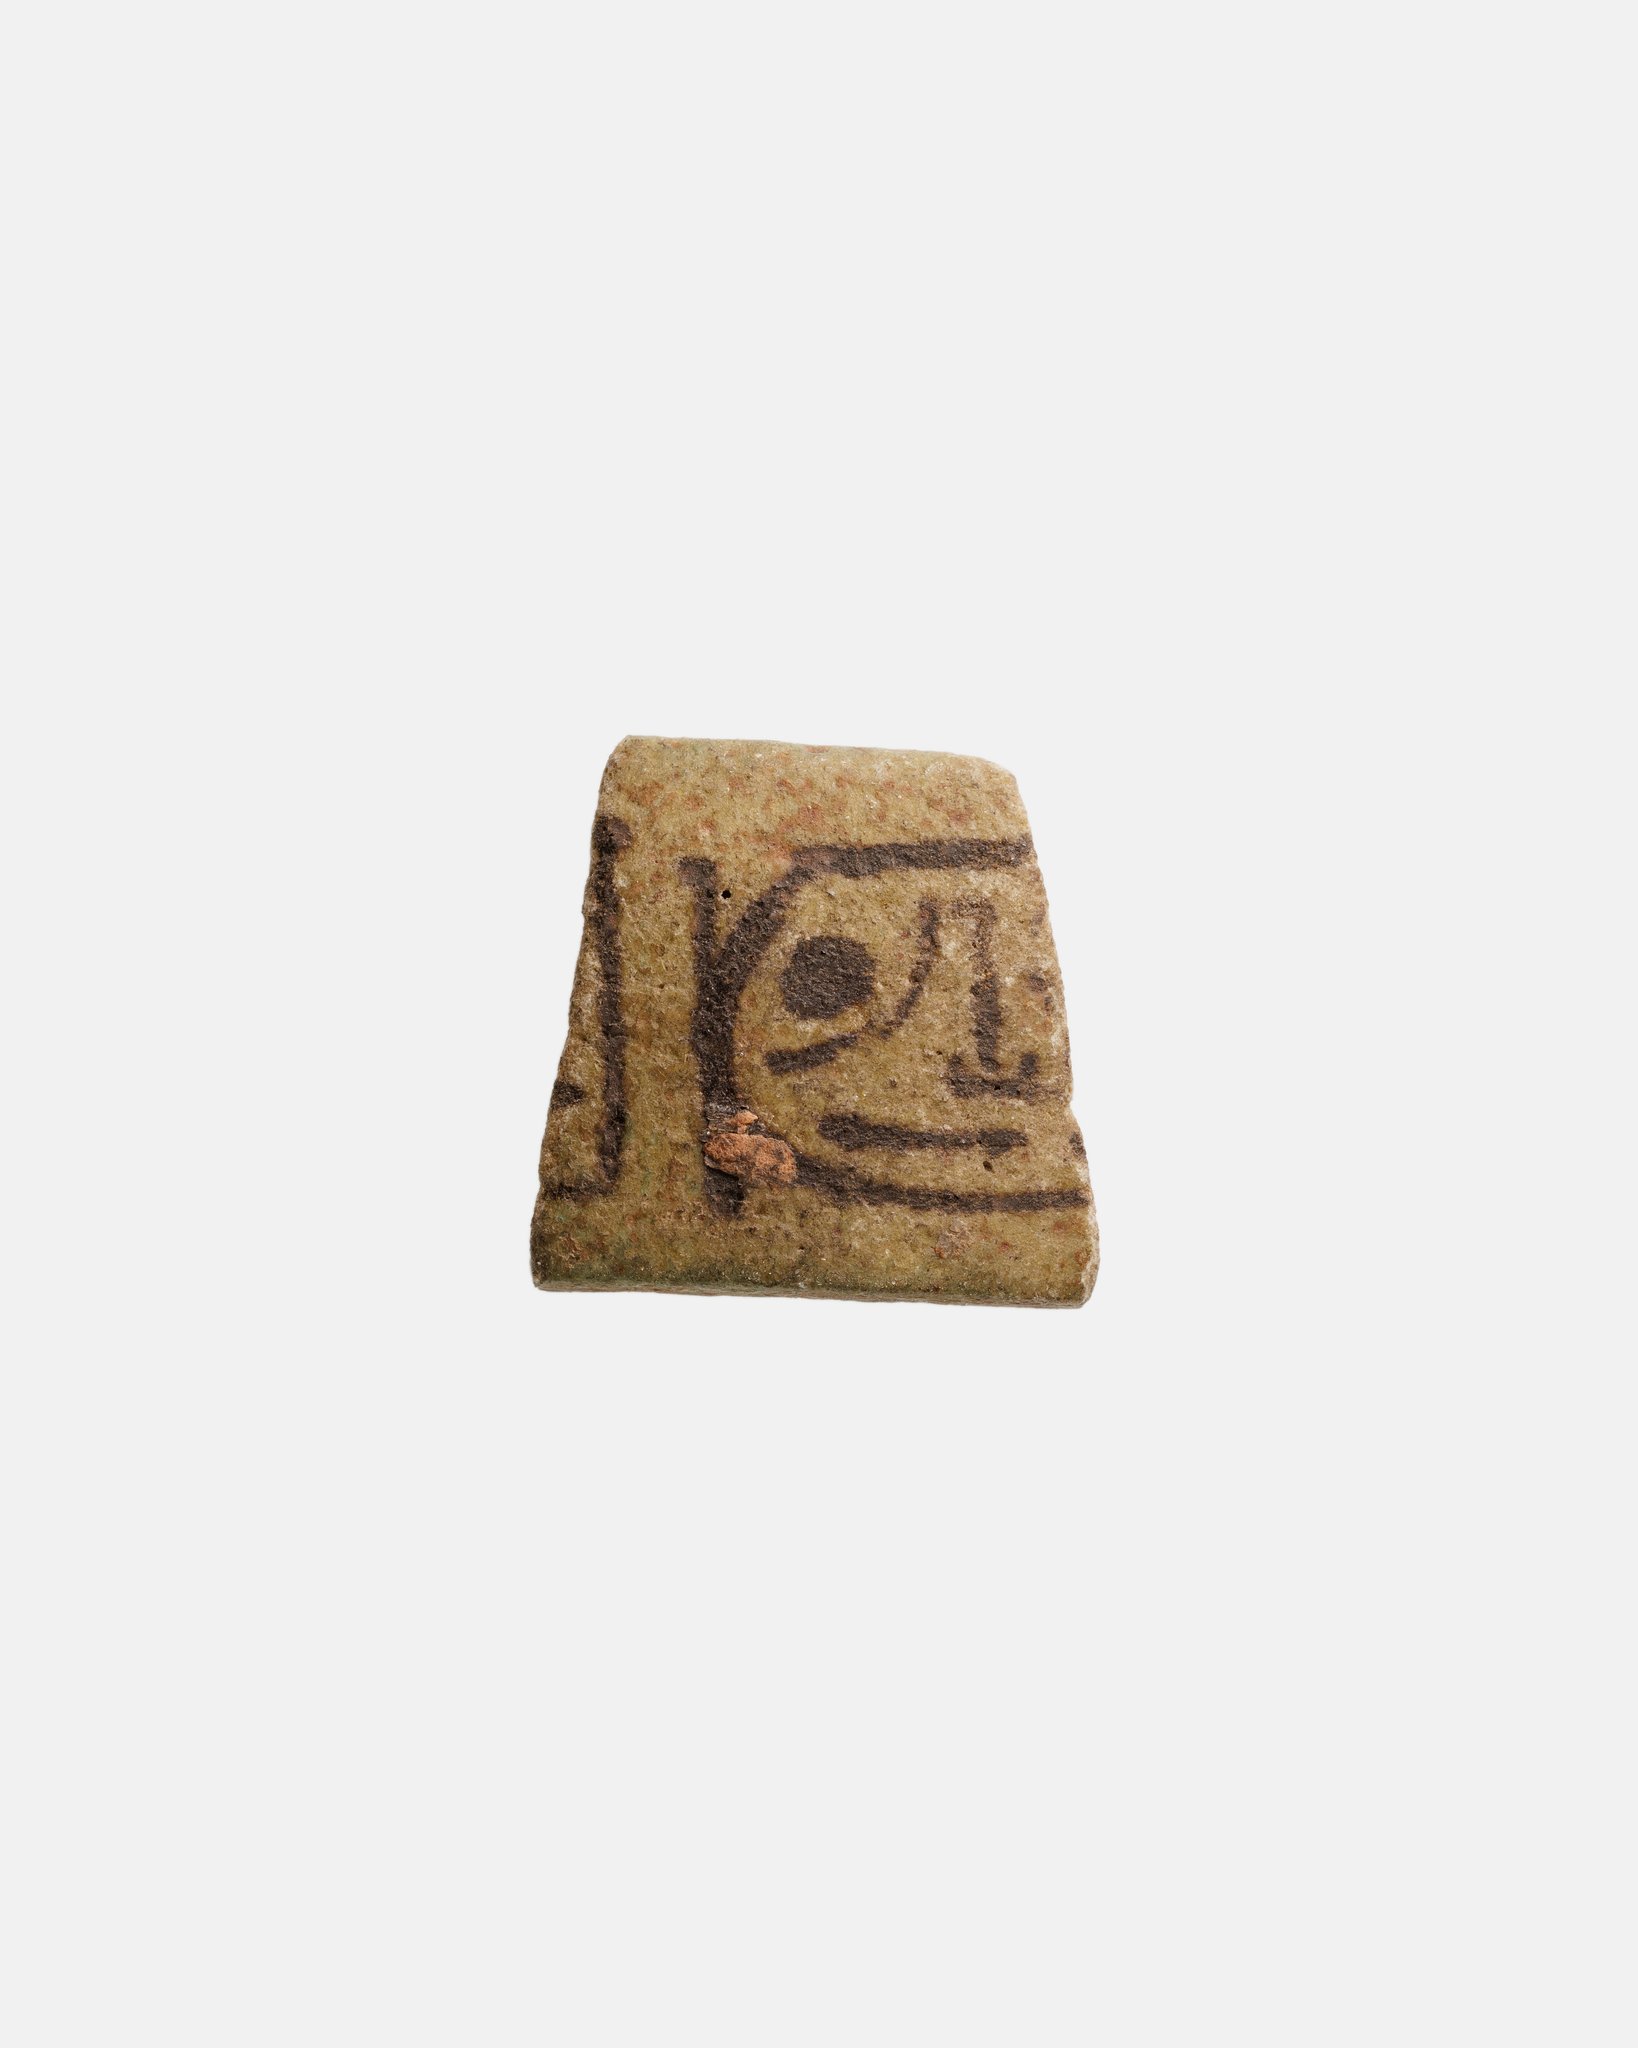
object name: votive bracelet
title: Fragment of a votive bracelet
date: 1295-1070 BCE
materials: faience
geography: egypt